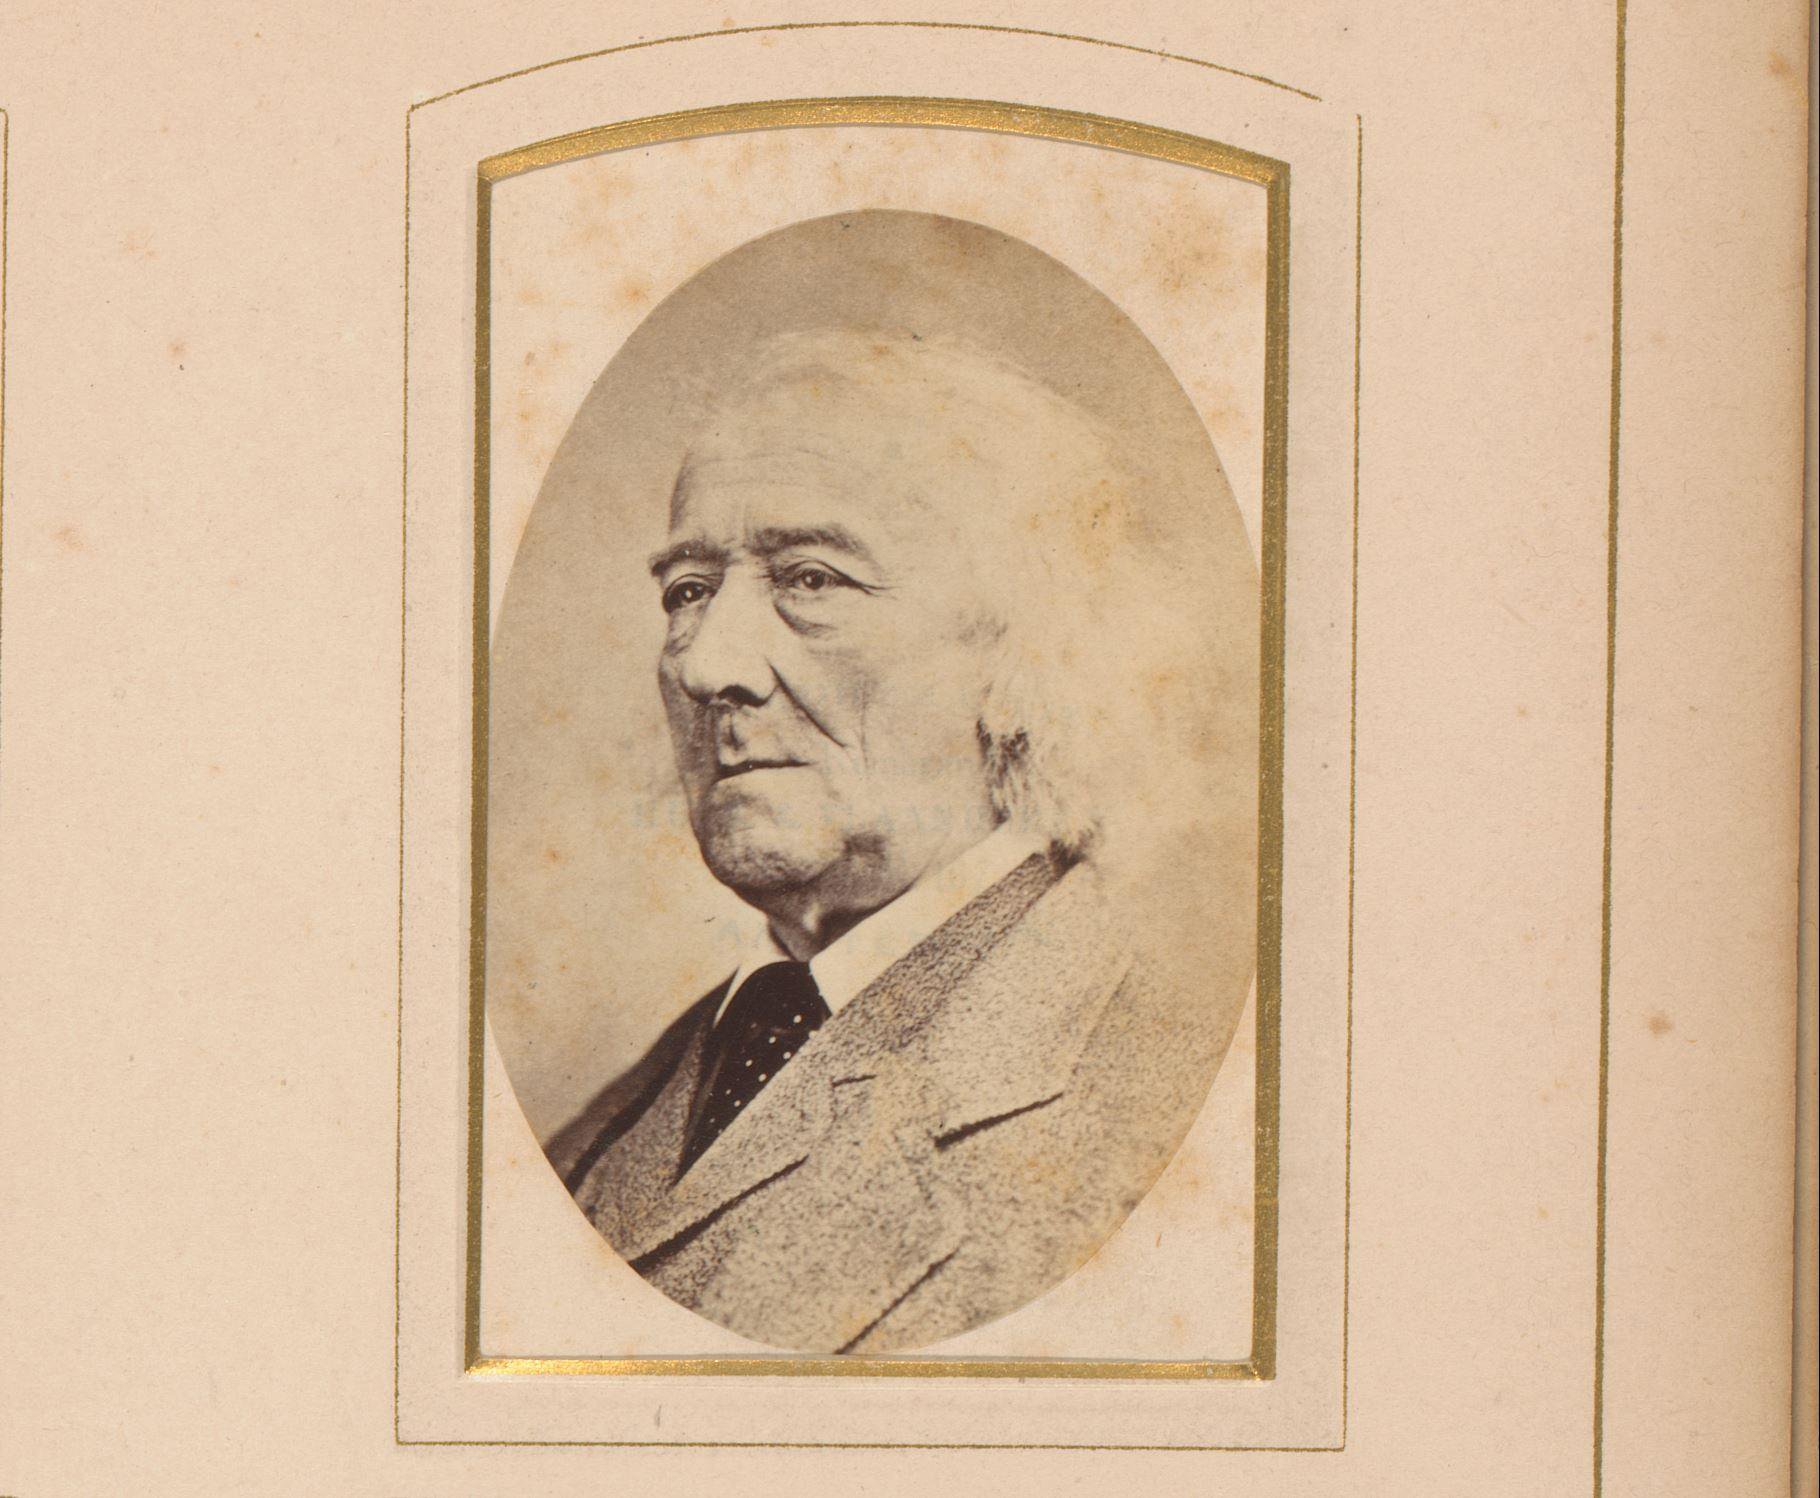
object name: album leaf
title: Portret van Jacob van Lennep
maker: Anonymous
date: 1855-1868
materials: cardboard, photographic support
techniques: albumen print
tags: amsterdam, jacob van lennep, historical persons, portrait of a writer